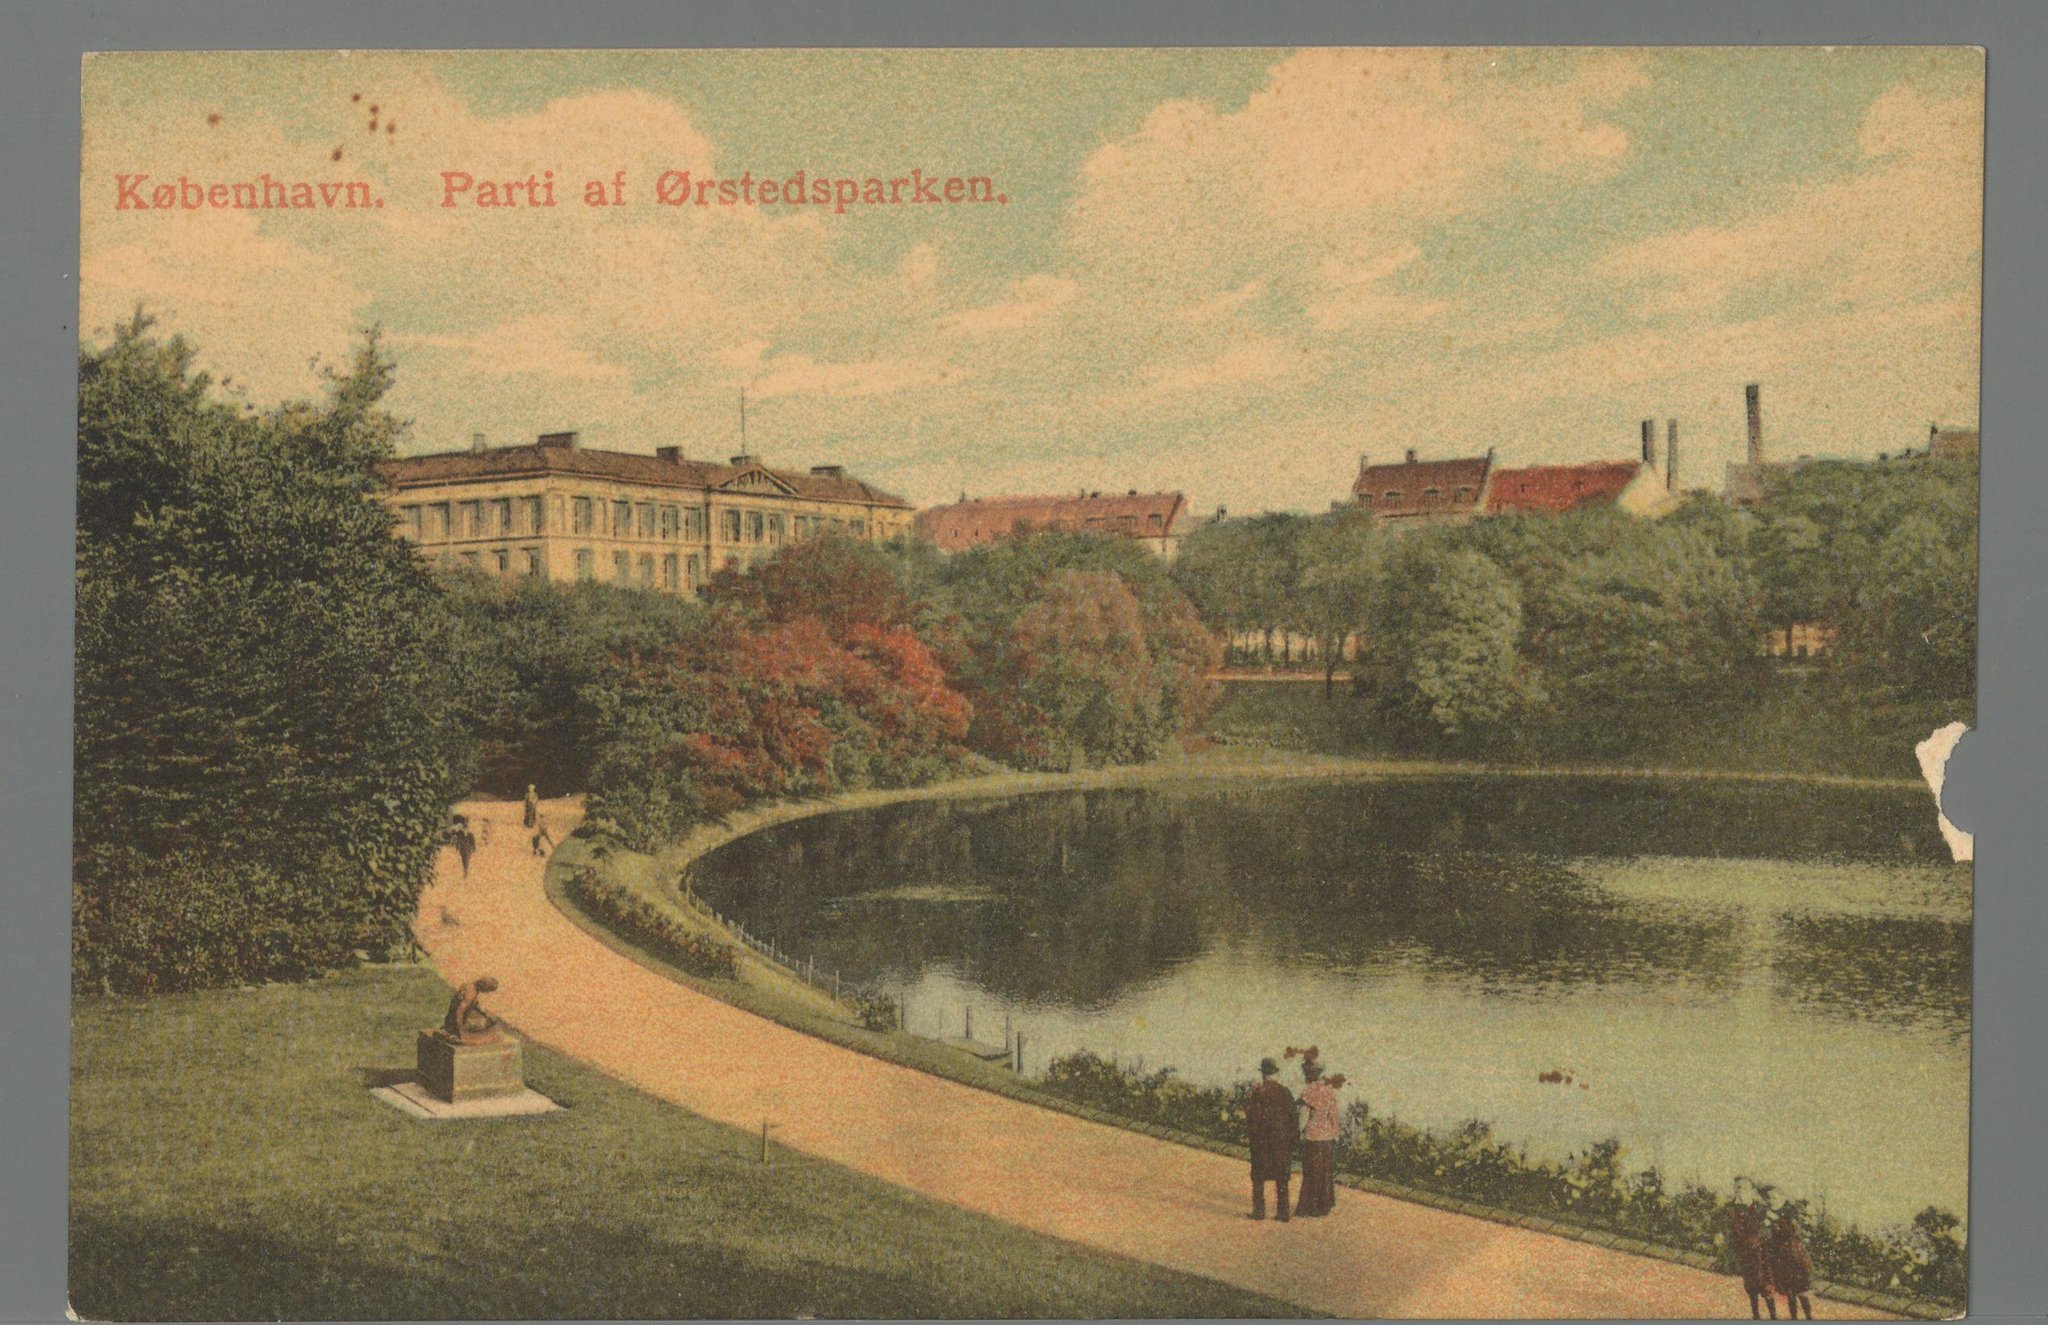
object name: photomechanical print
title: København. Parti af Ørstedsparken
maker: Anonymous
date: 1906-1920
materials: cardboard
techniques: photograph, lithograph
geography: copenhagen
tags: public gardens, park (+ city(-scape) with figures, staffage), garden pond, copenhagen (city)